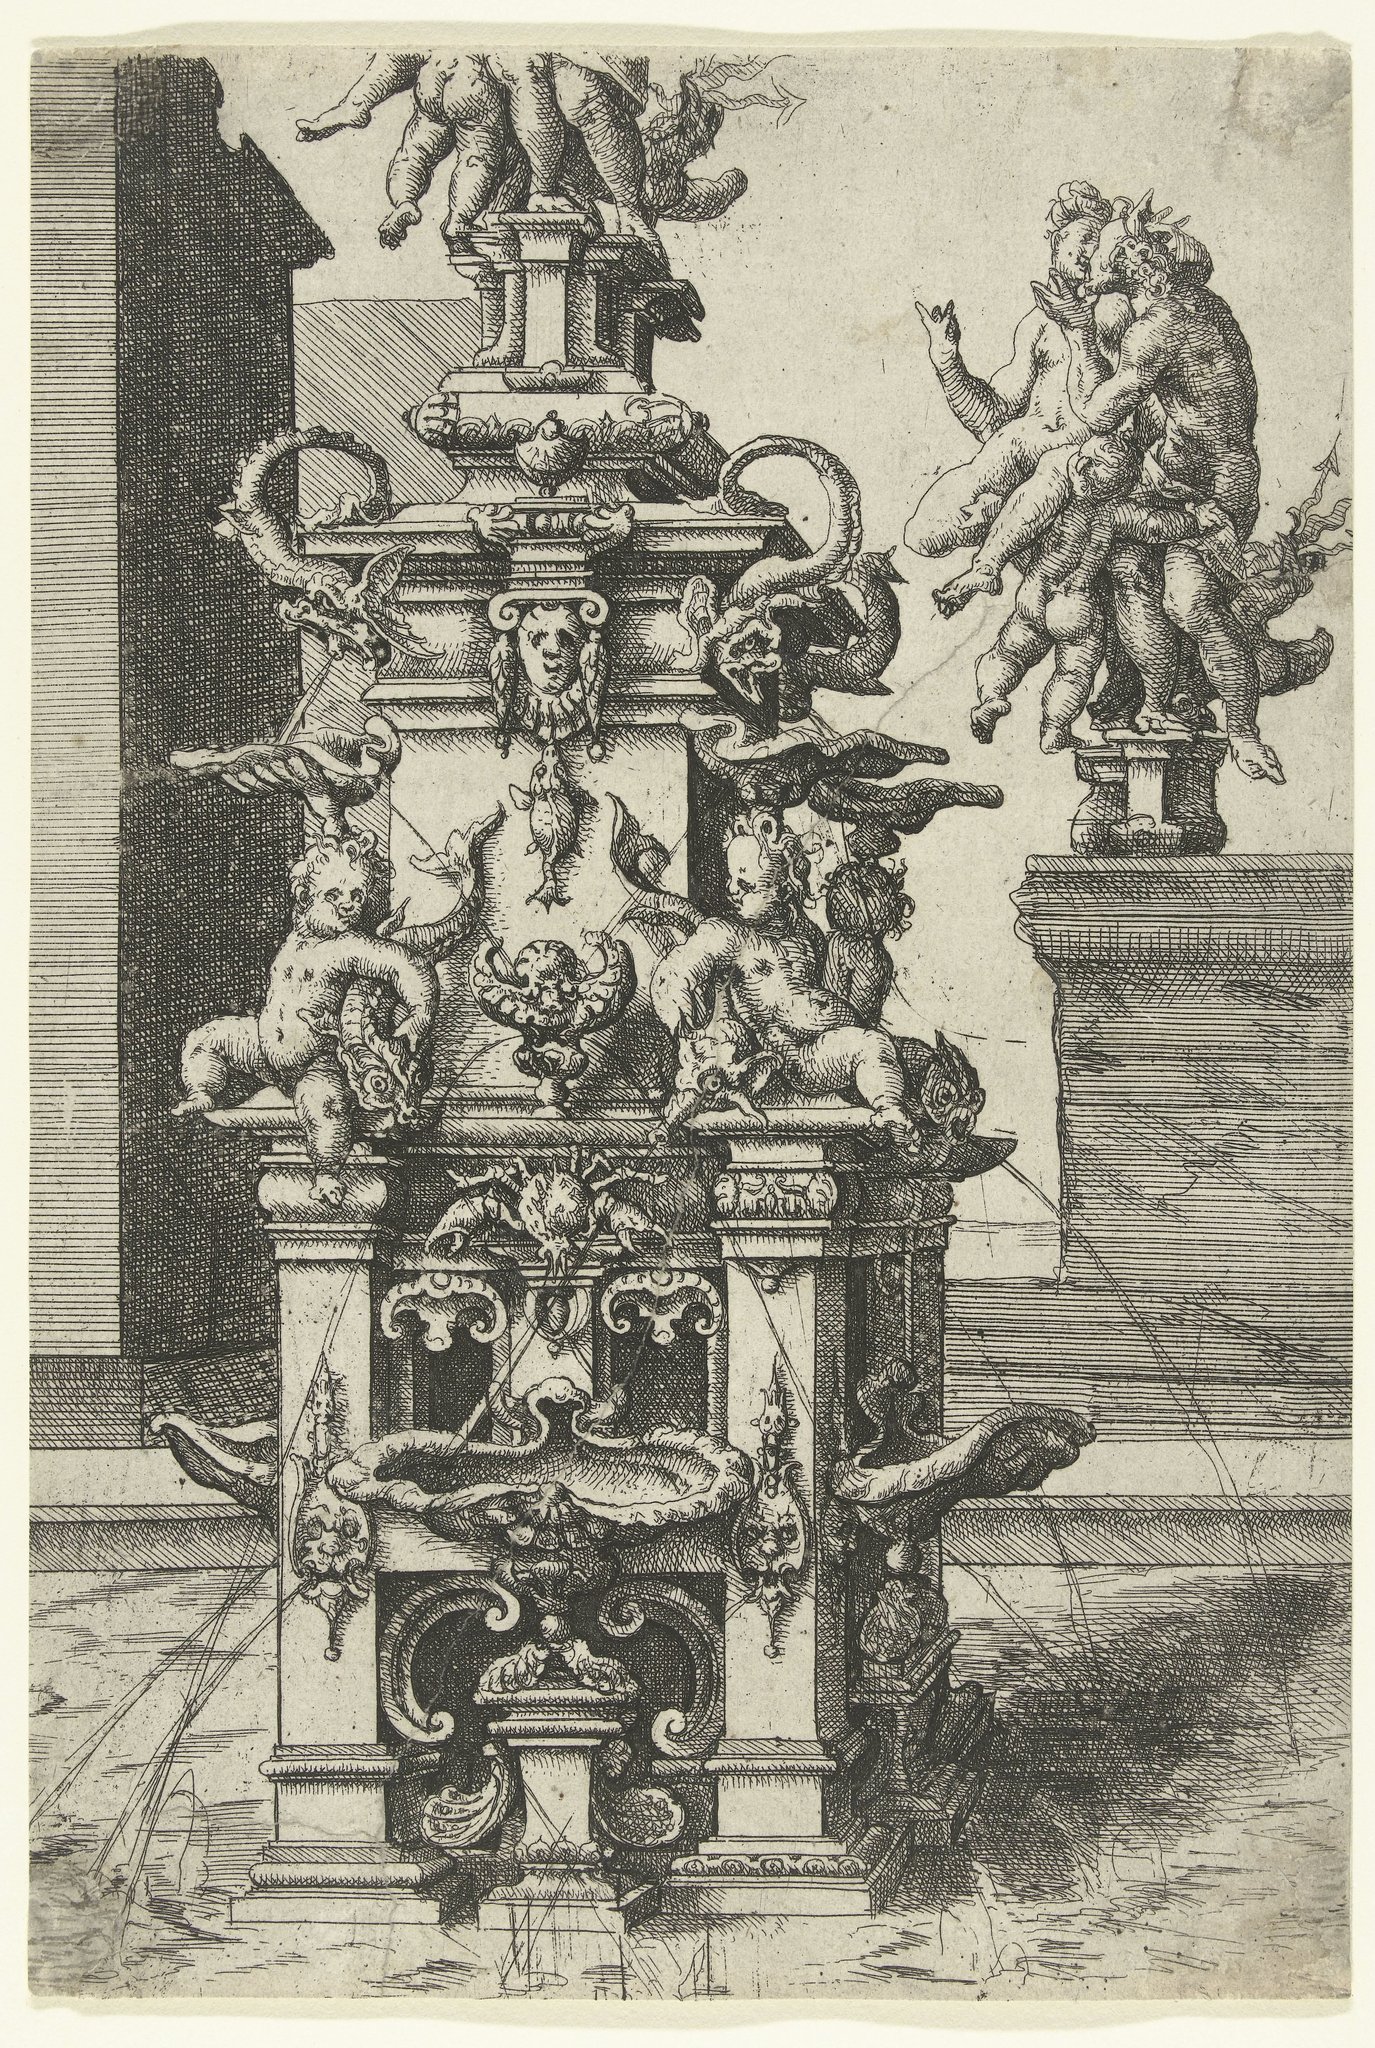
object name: ornament print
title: Fontein met Jupiter en Juno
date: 1560-1598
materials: paper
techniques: etching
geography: germany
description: De schacht van de fontein is gedecoreerd met schelpvormige bekkens en kinderen met waterspuwende vissen. Rechts is de bekroning van de fontein weergegeven. Eén van 20 bladen uit een serie (Architectura. Von Ausztheilung, Symmetria und Proportion der fünff Seulen...) bestaande uit 193 bladen en 5 titelbladen, verdeeld over vijf boeken. Het gaat hier om een tweede, uitgebreide editie van de onder Orn Cat I-319 beschreven serie.